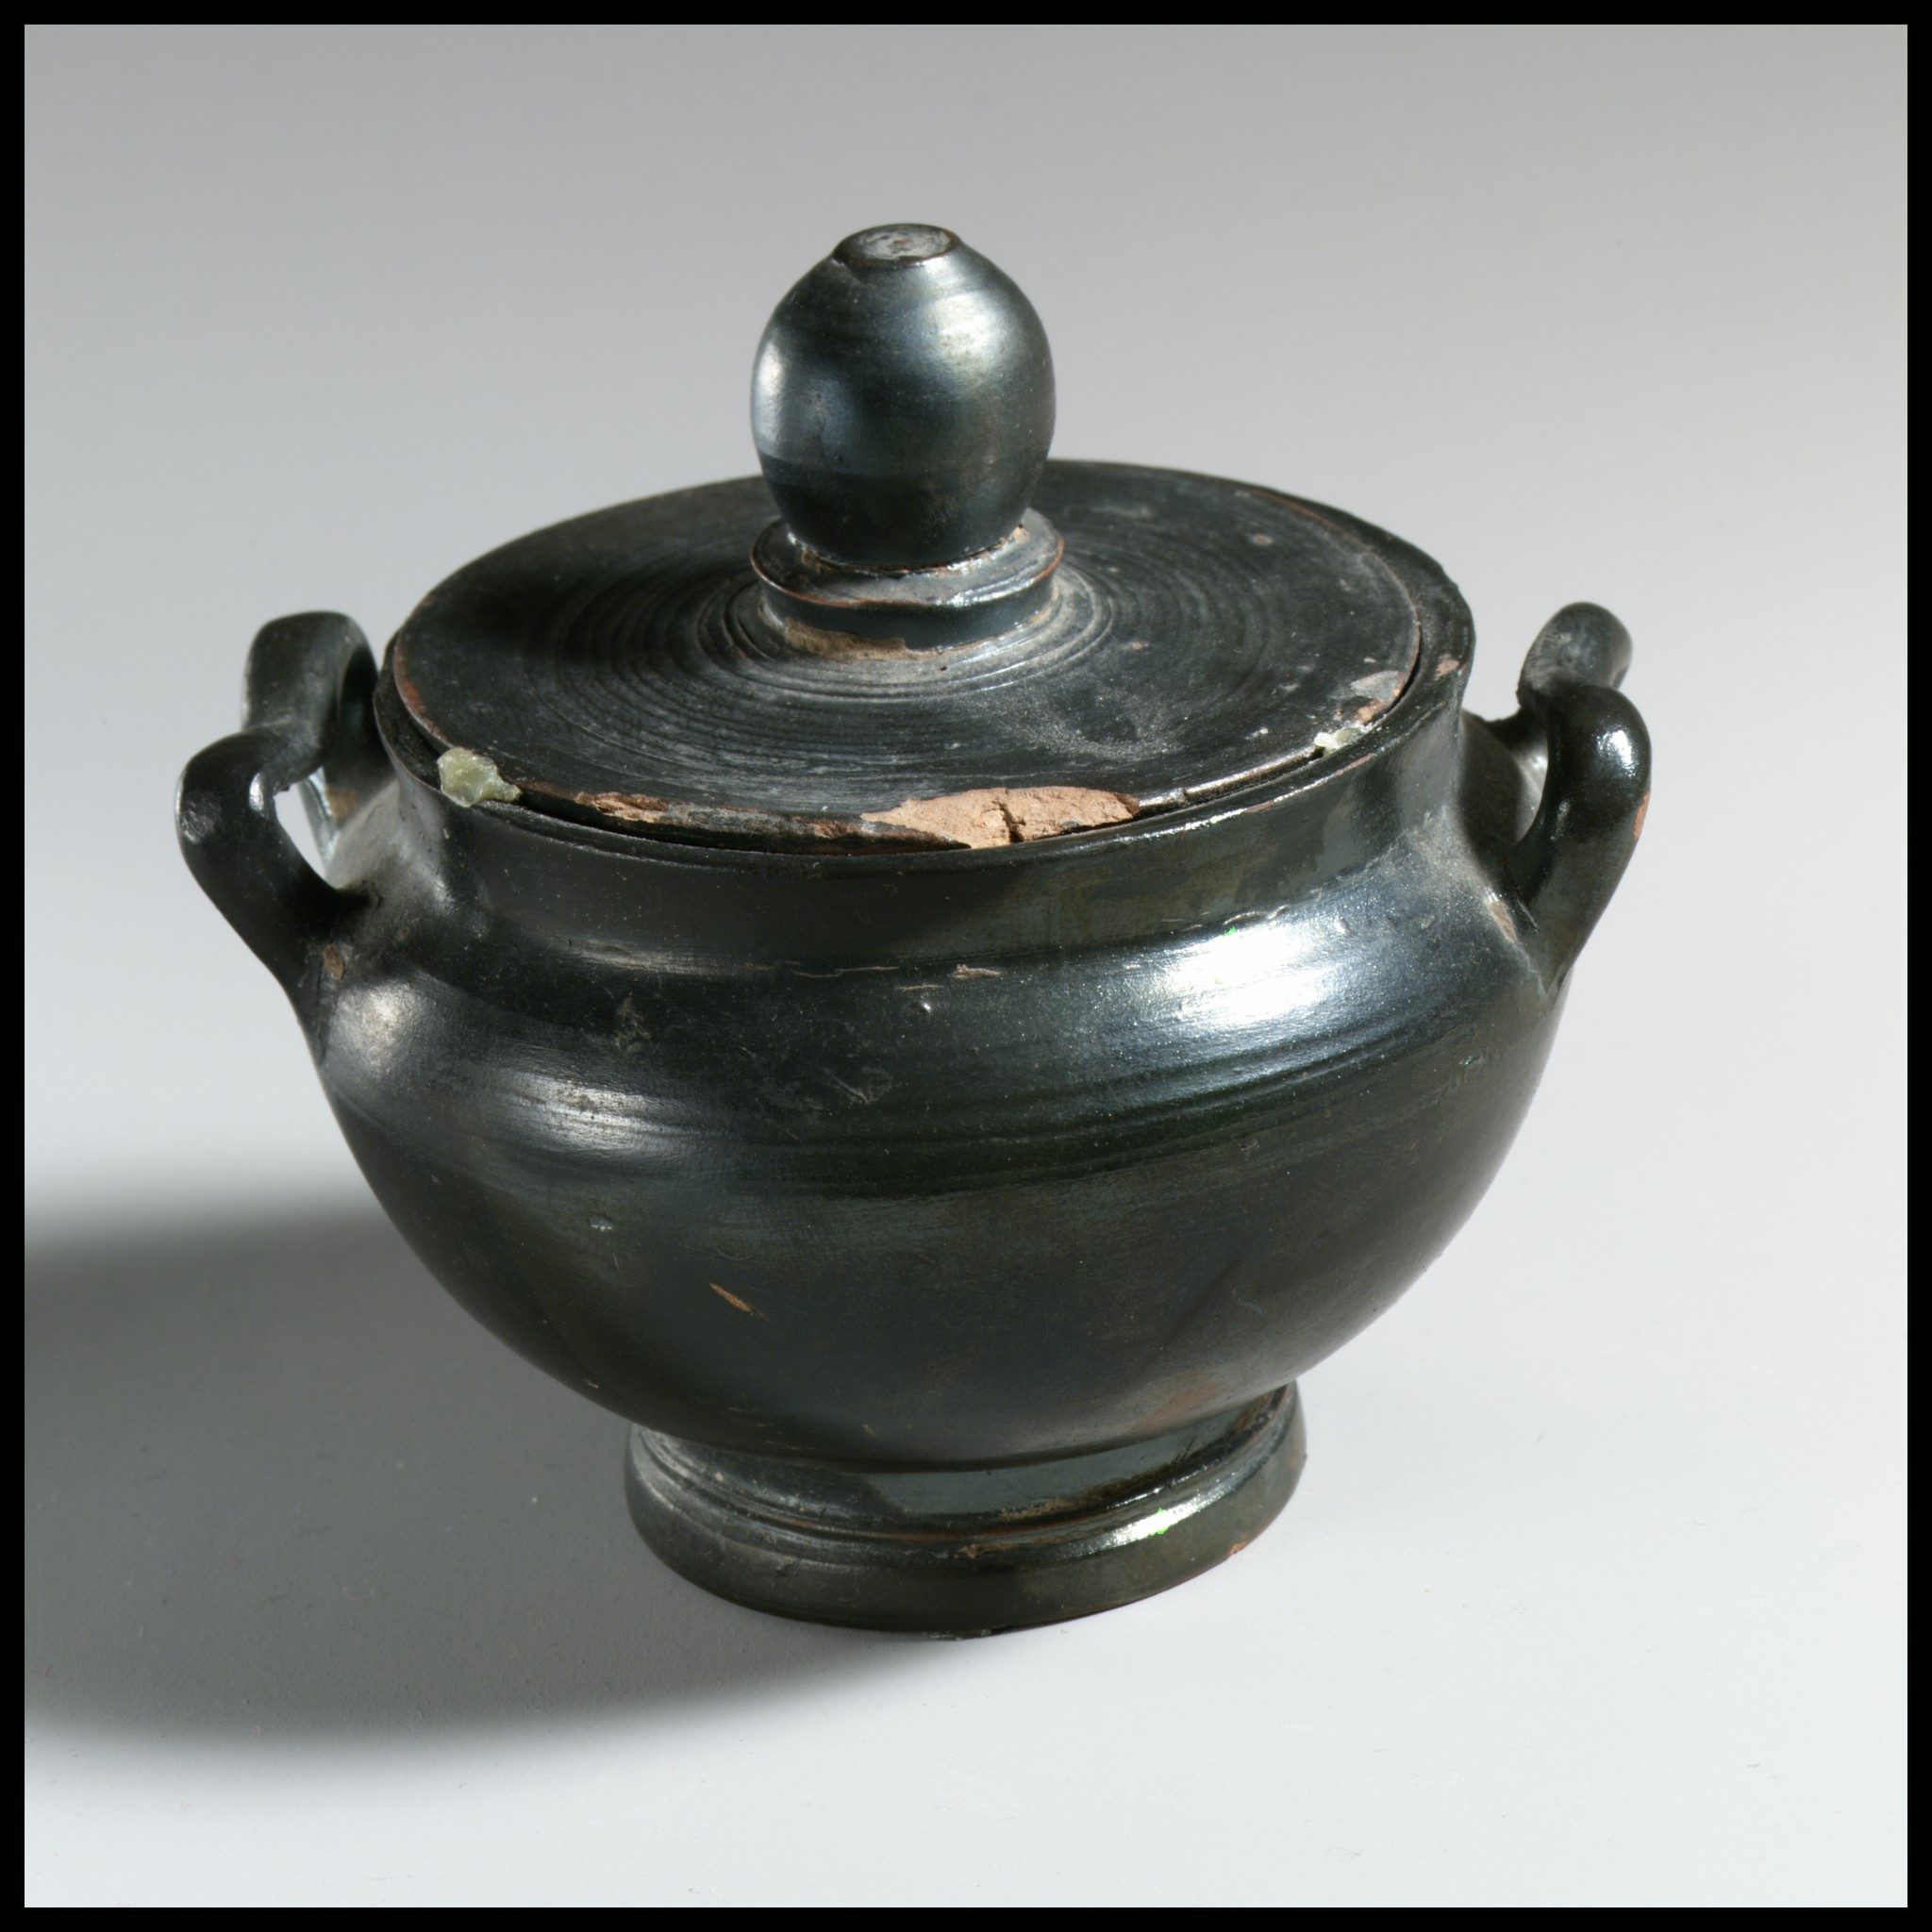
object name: pyxis with lid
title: Terracotta pyxis (box)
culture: greek or south italian or campanian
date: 400-201 BCE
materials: terracotta